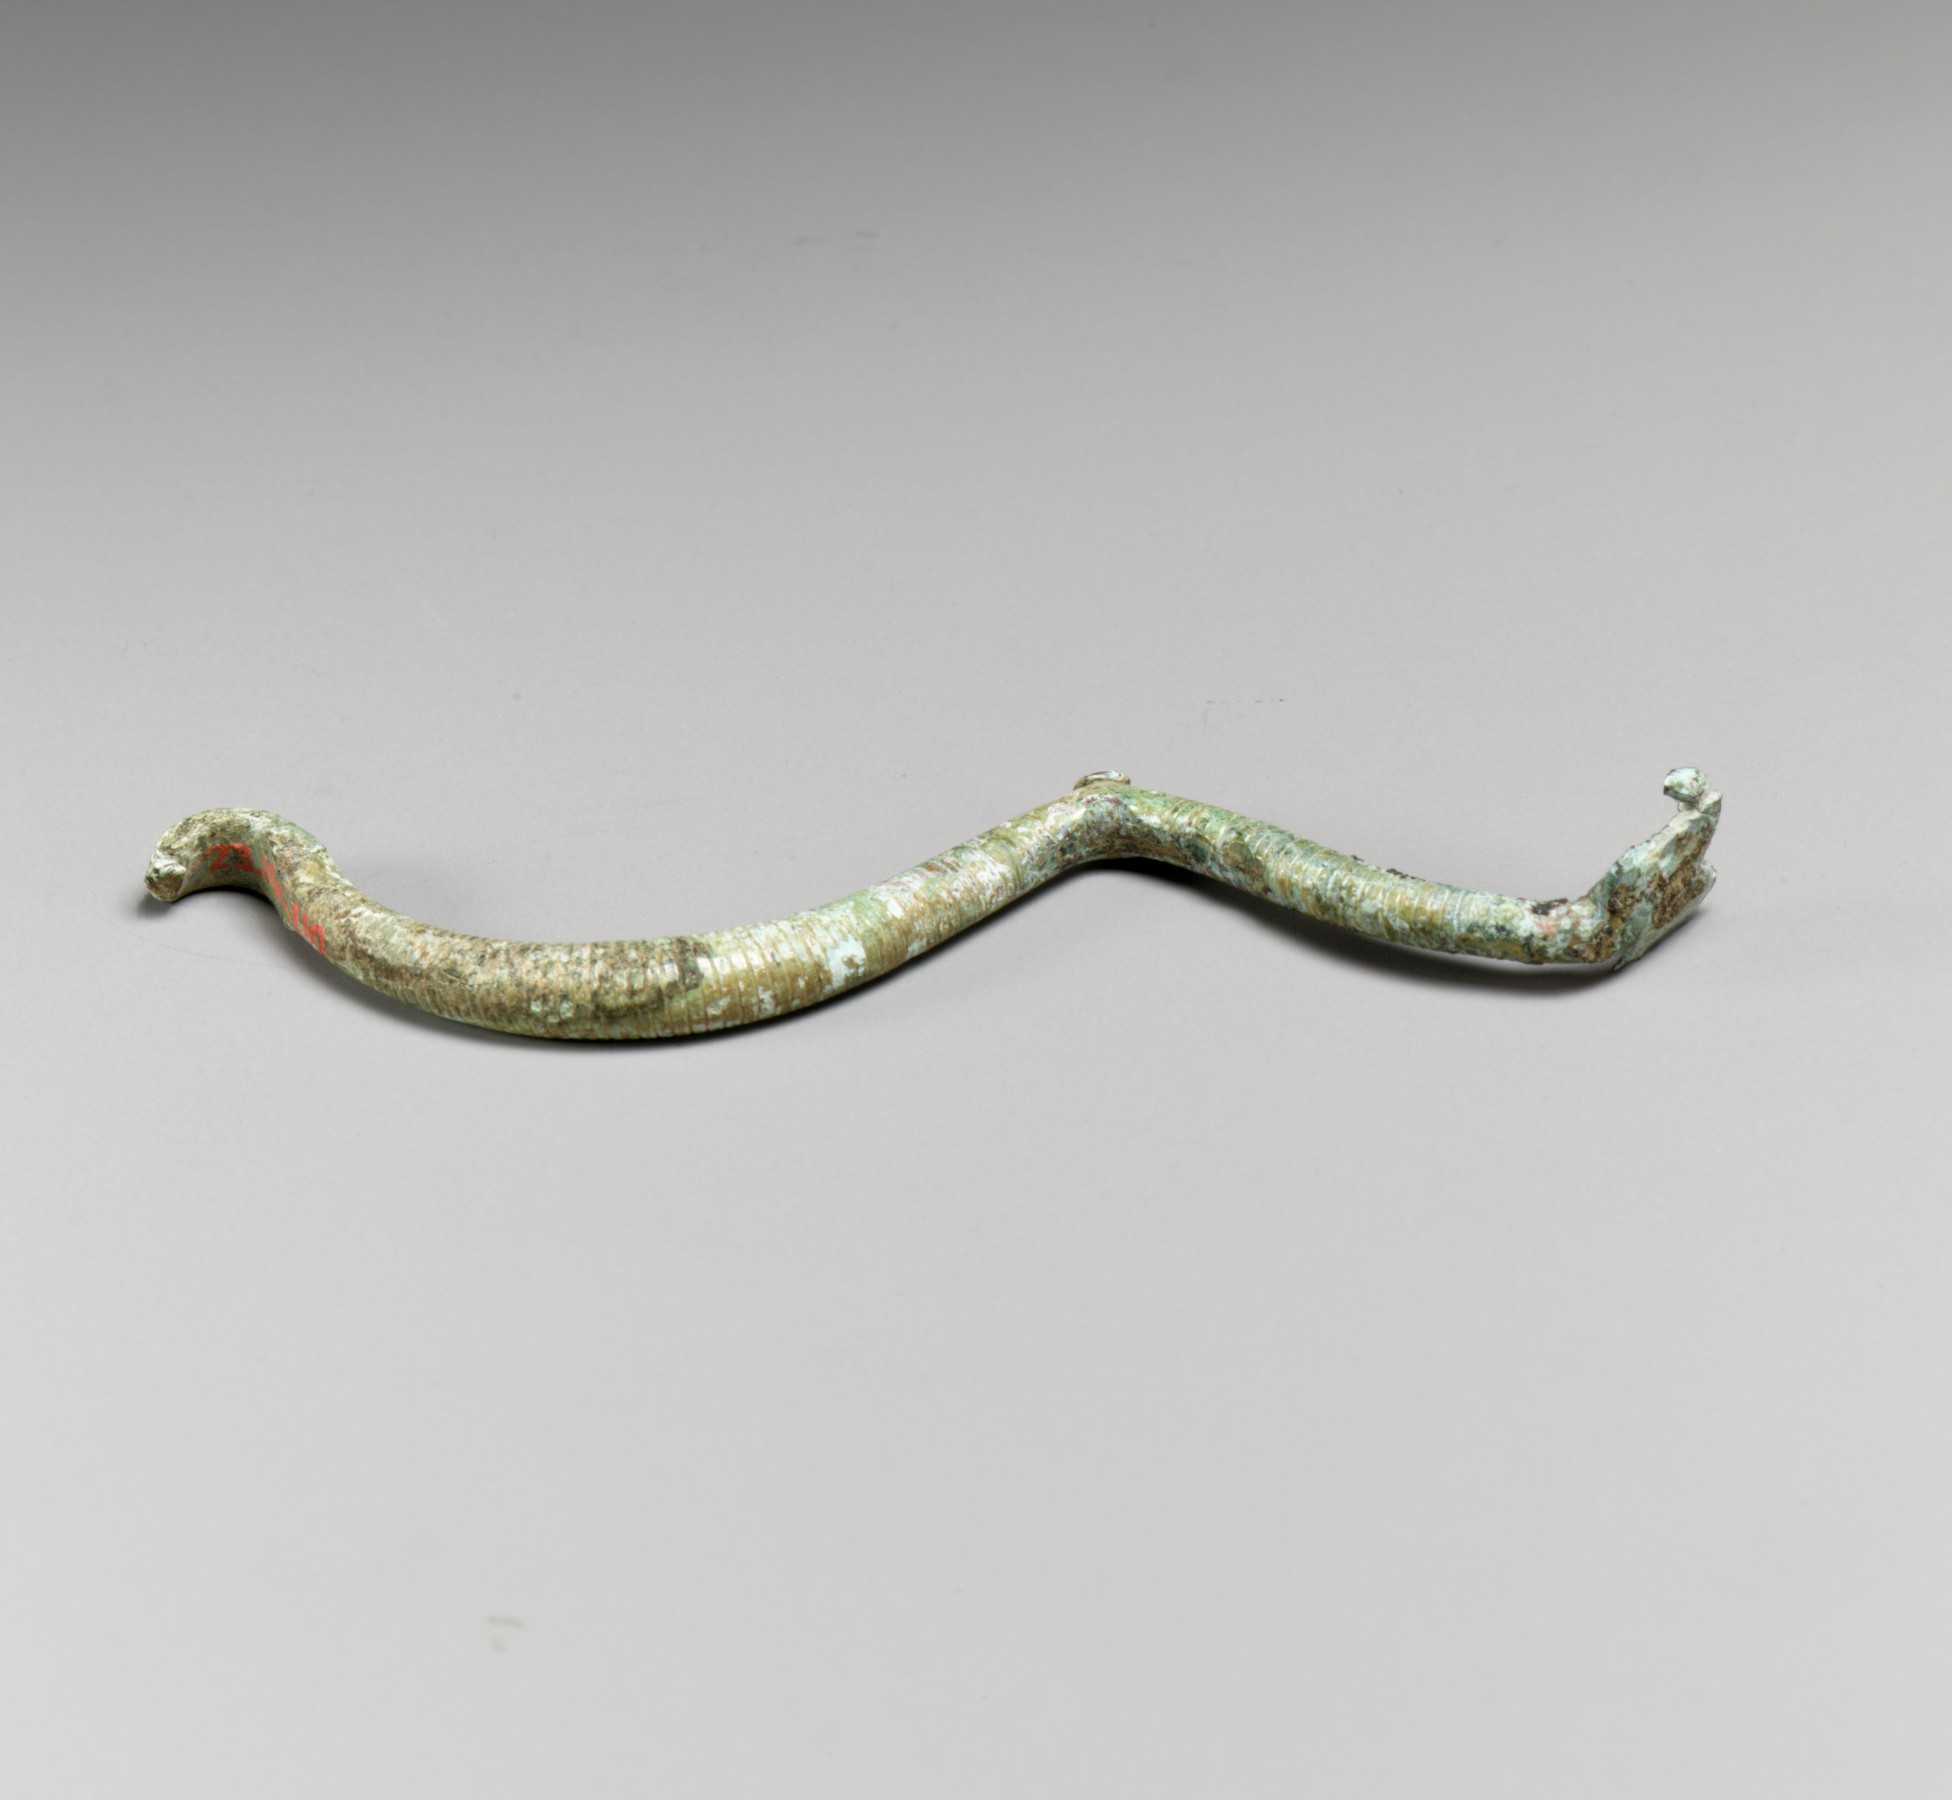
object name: fibula, fragment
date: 7000 BCE-330 CE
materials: bronze